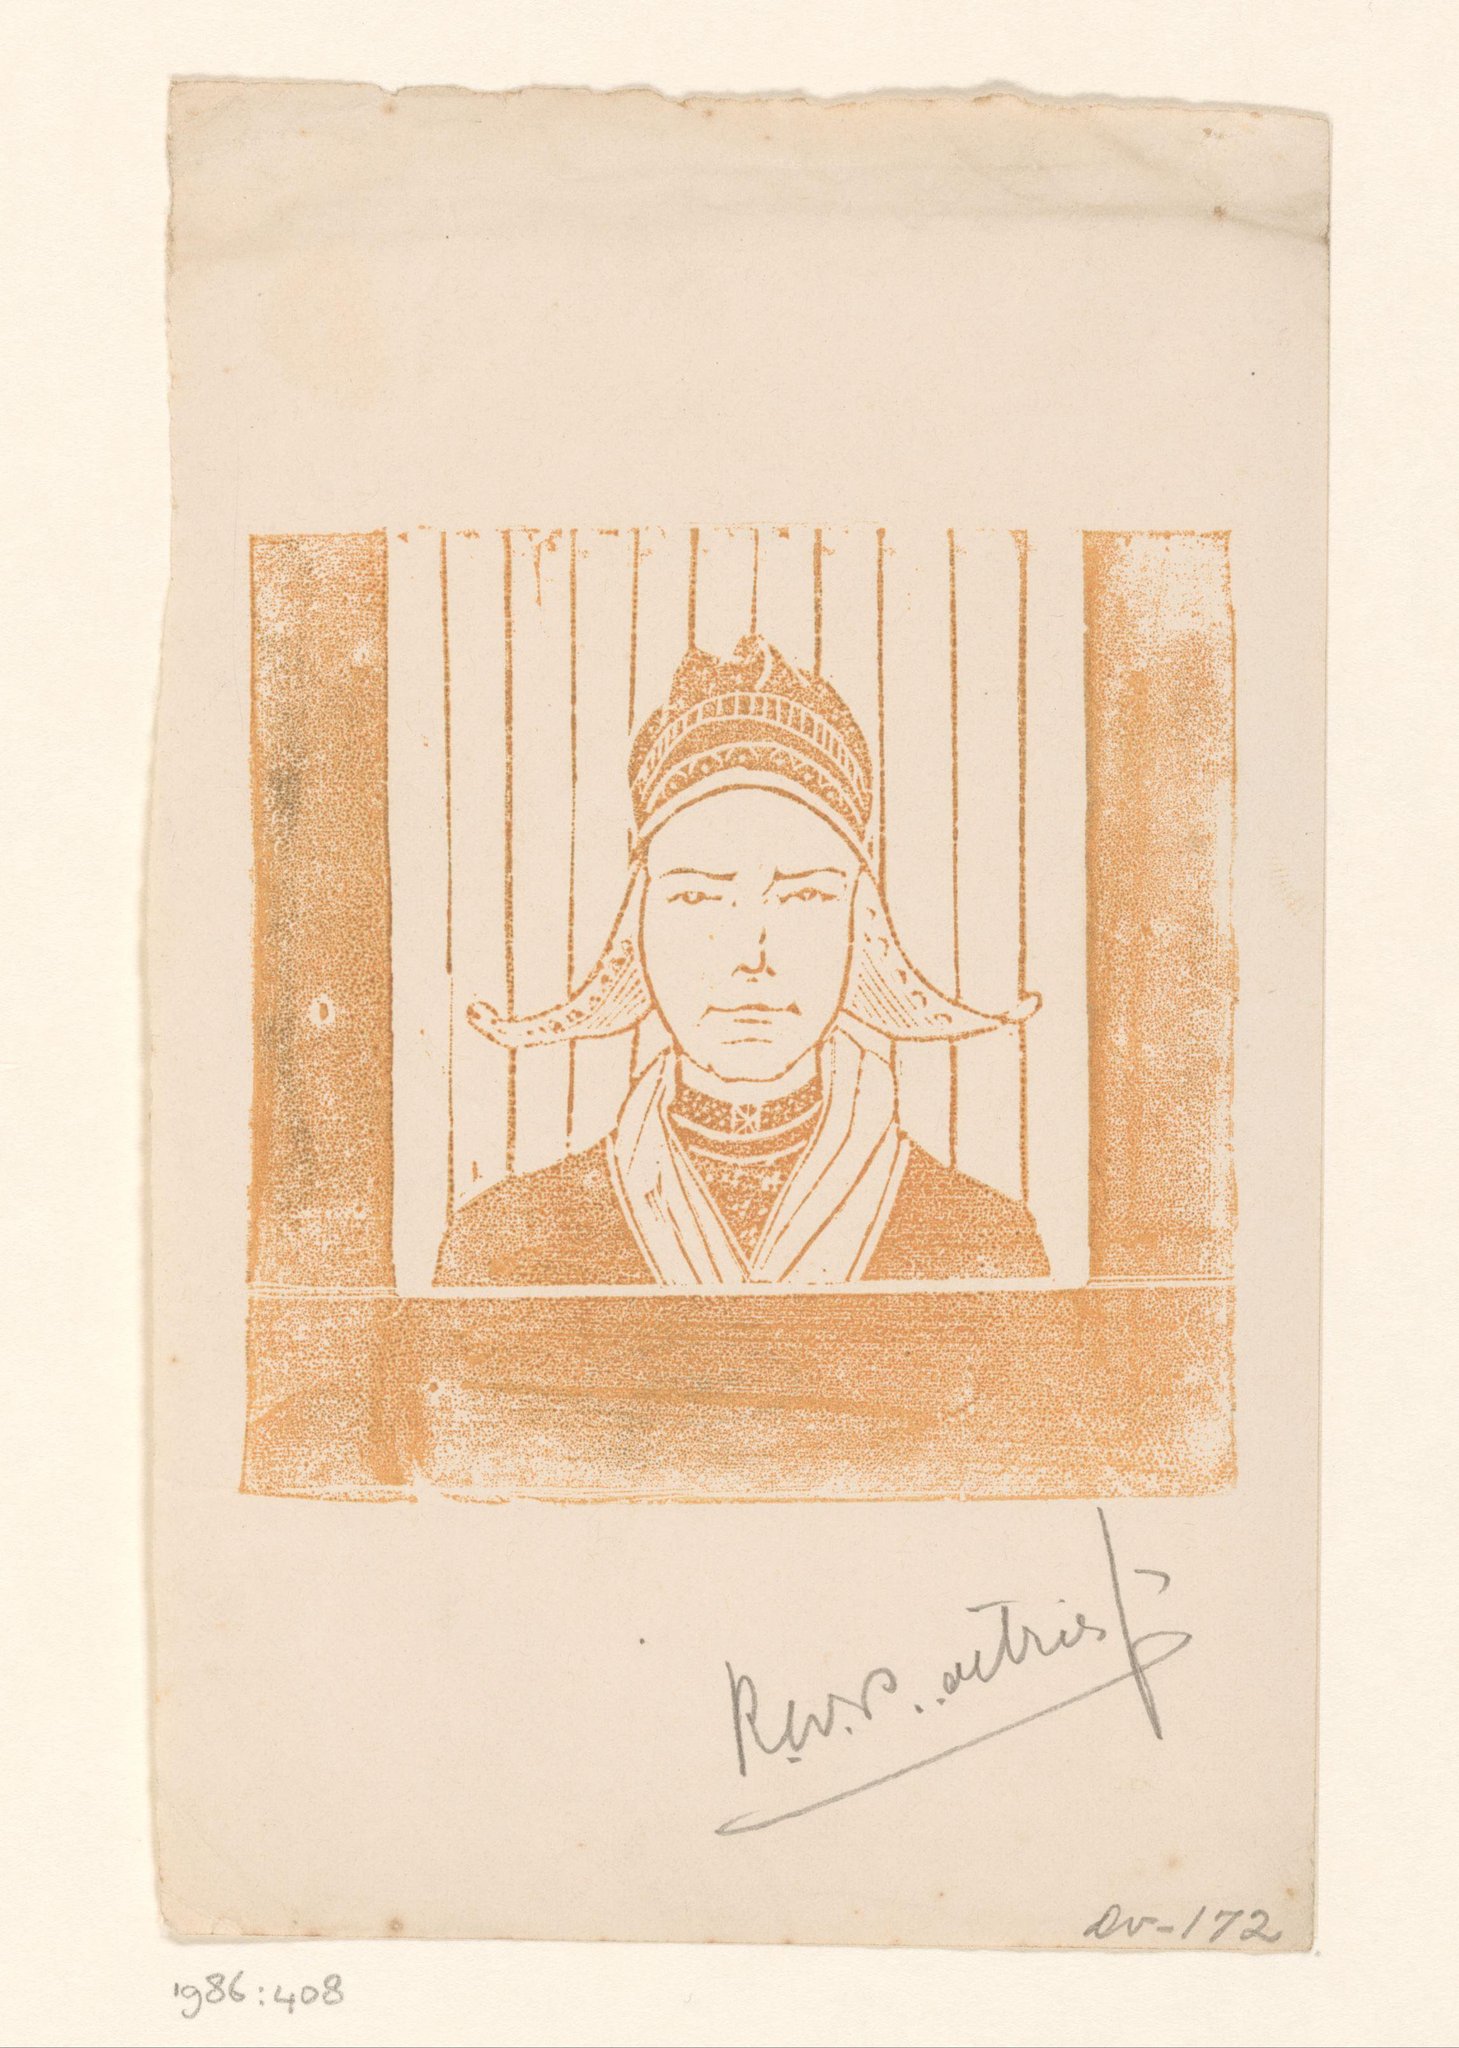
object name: print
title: Volendams meisje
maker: reinier willem petrus de vries (1874-1953)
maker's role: draughtsman, print maker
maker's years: 1874-1953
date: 1884-1952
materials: paper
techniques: linocut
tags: girl (child between toddler and youth), folk costume, regional costume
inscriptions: collector's mark: Lugt 2228